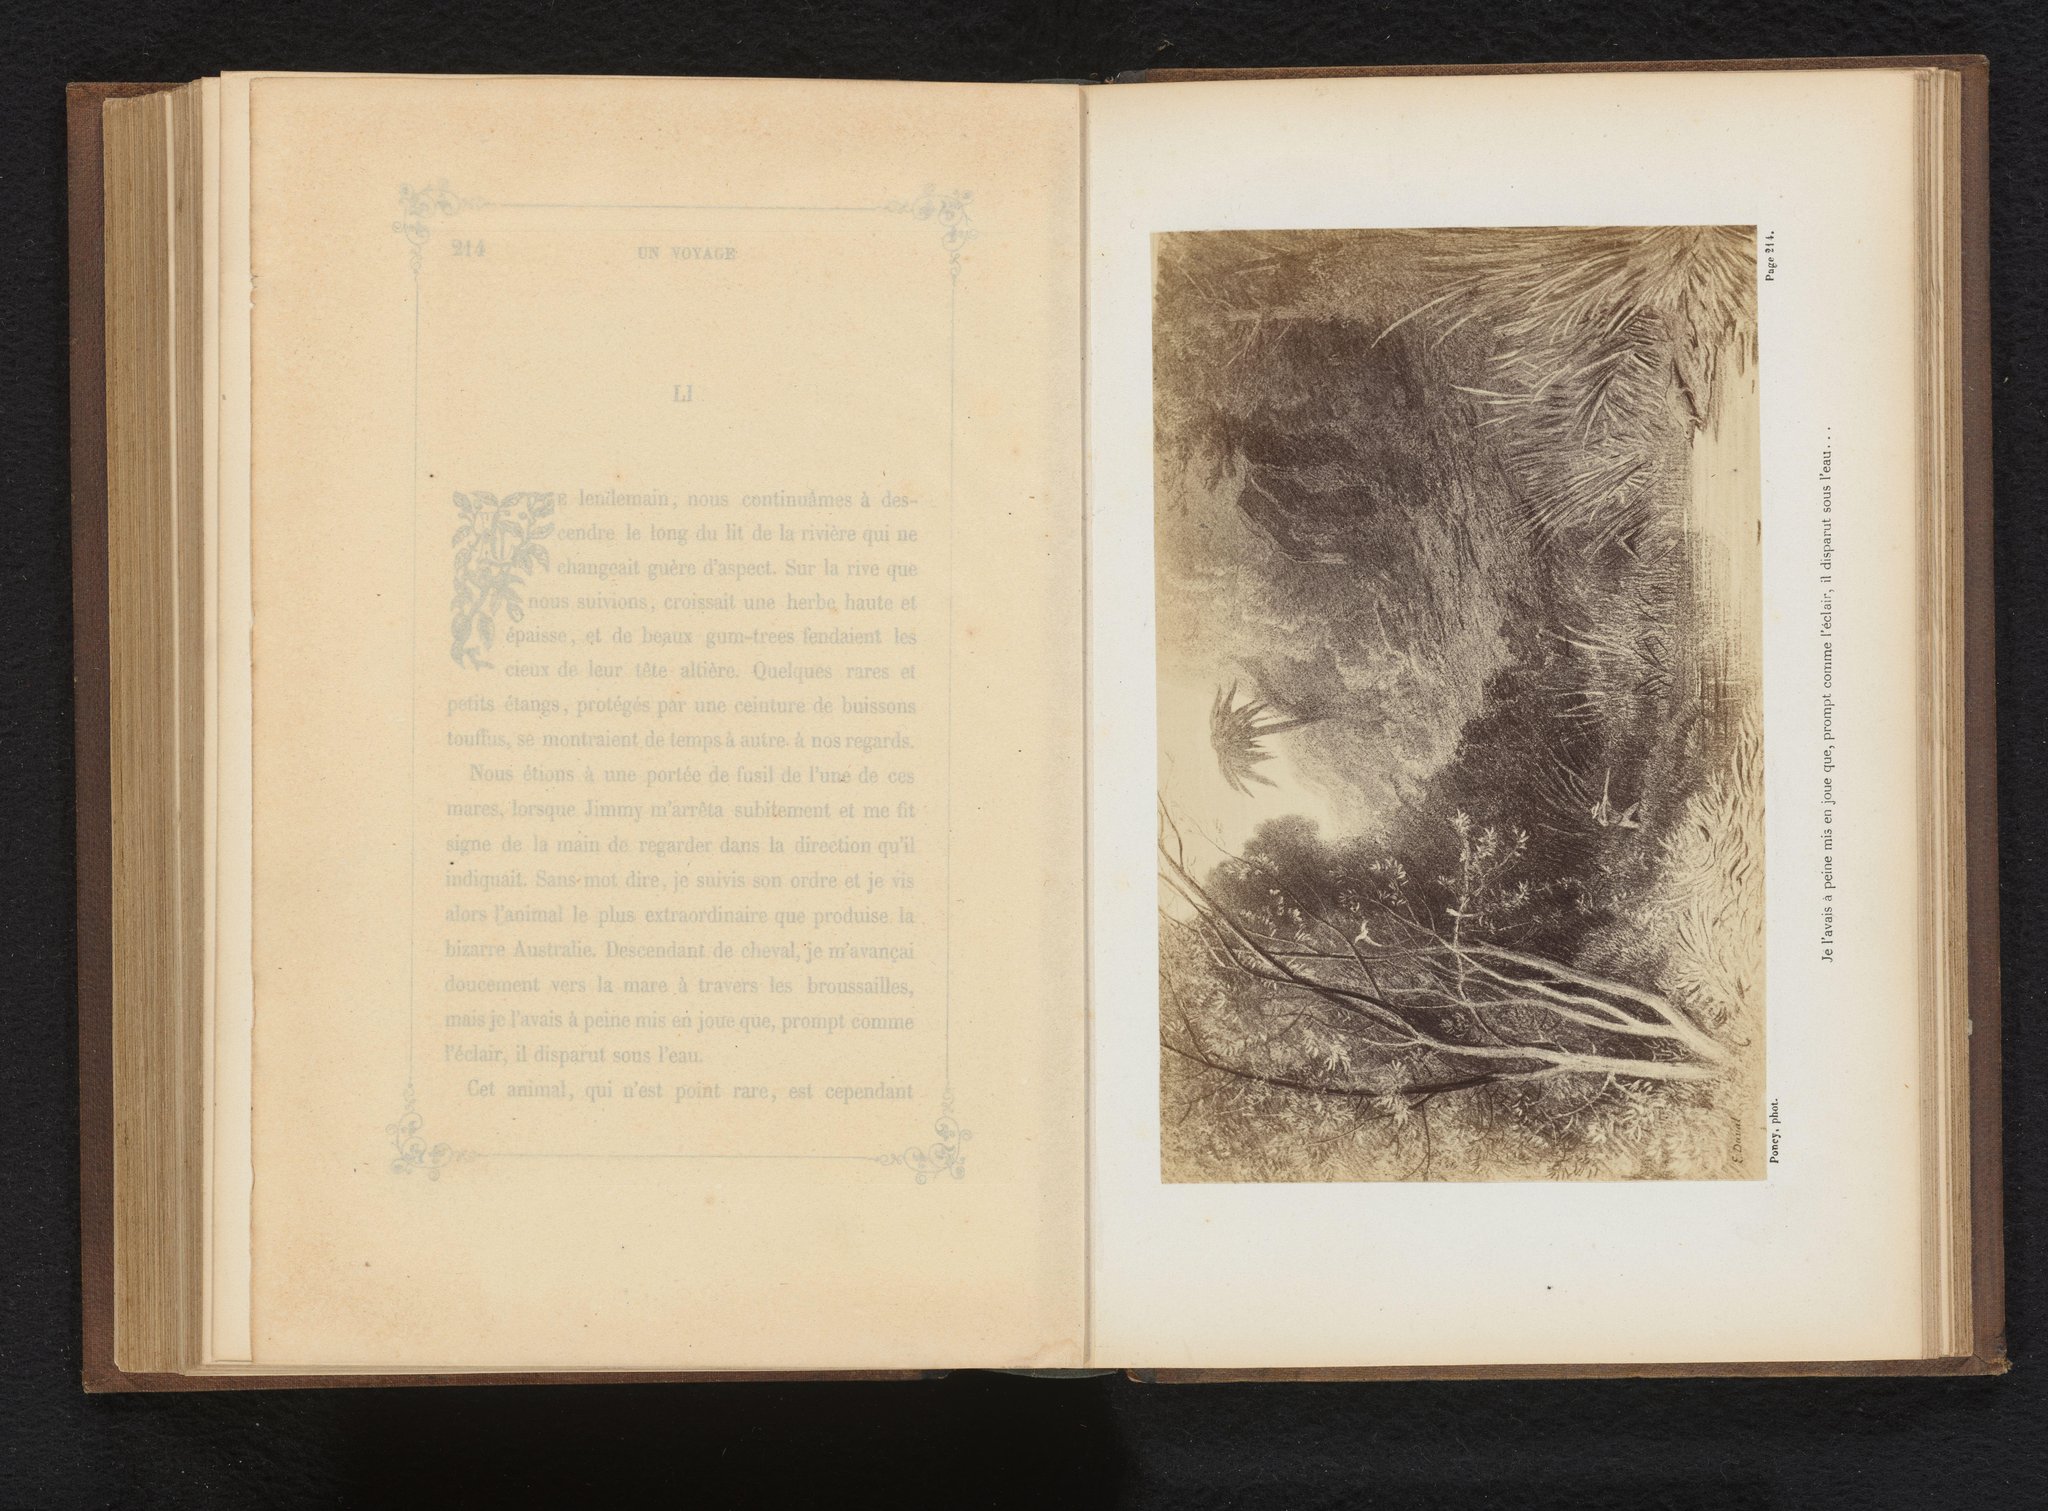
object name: page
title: Je l'avais à peine mis en joue que, prompt comme l'éclair, il disparut sous l'eau...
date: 1863-1868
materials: paper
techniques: albumen print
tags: hunter, other mammals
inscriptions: inscription: ‘Page 214.’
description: Foto op ongenummerde pagina na pagina 214.